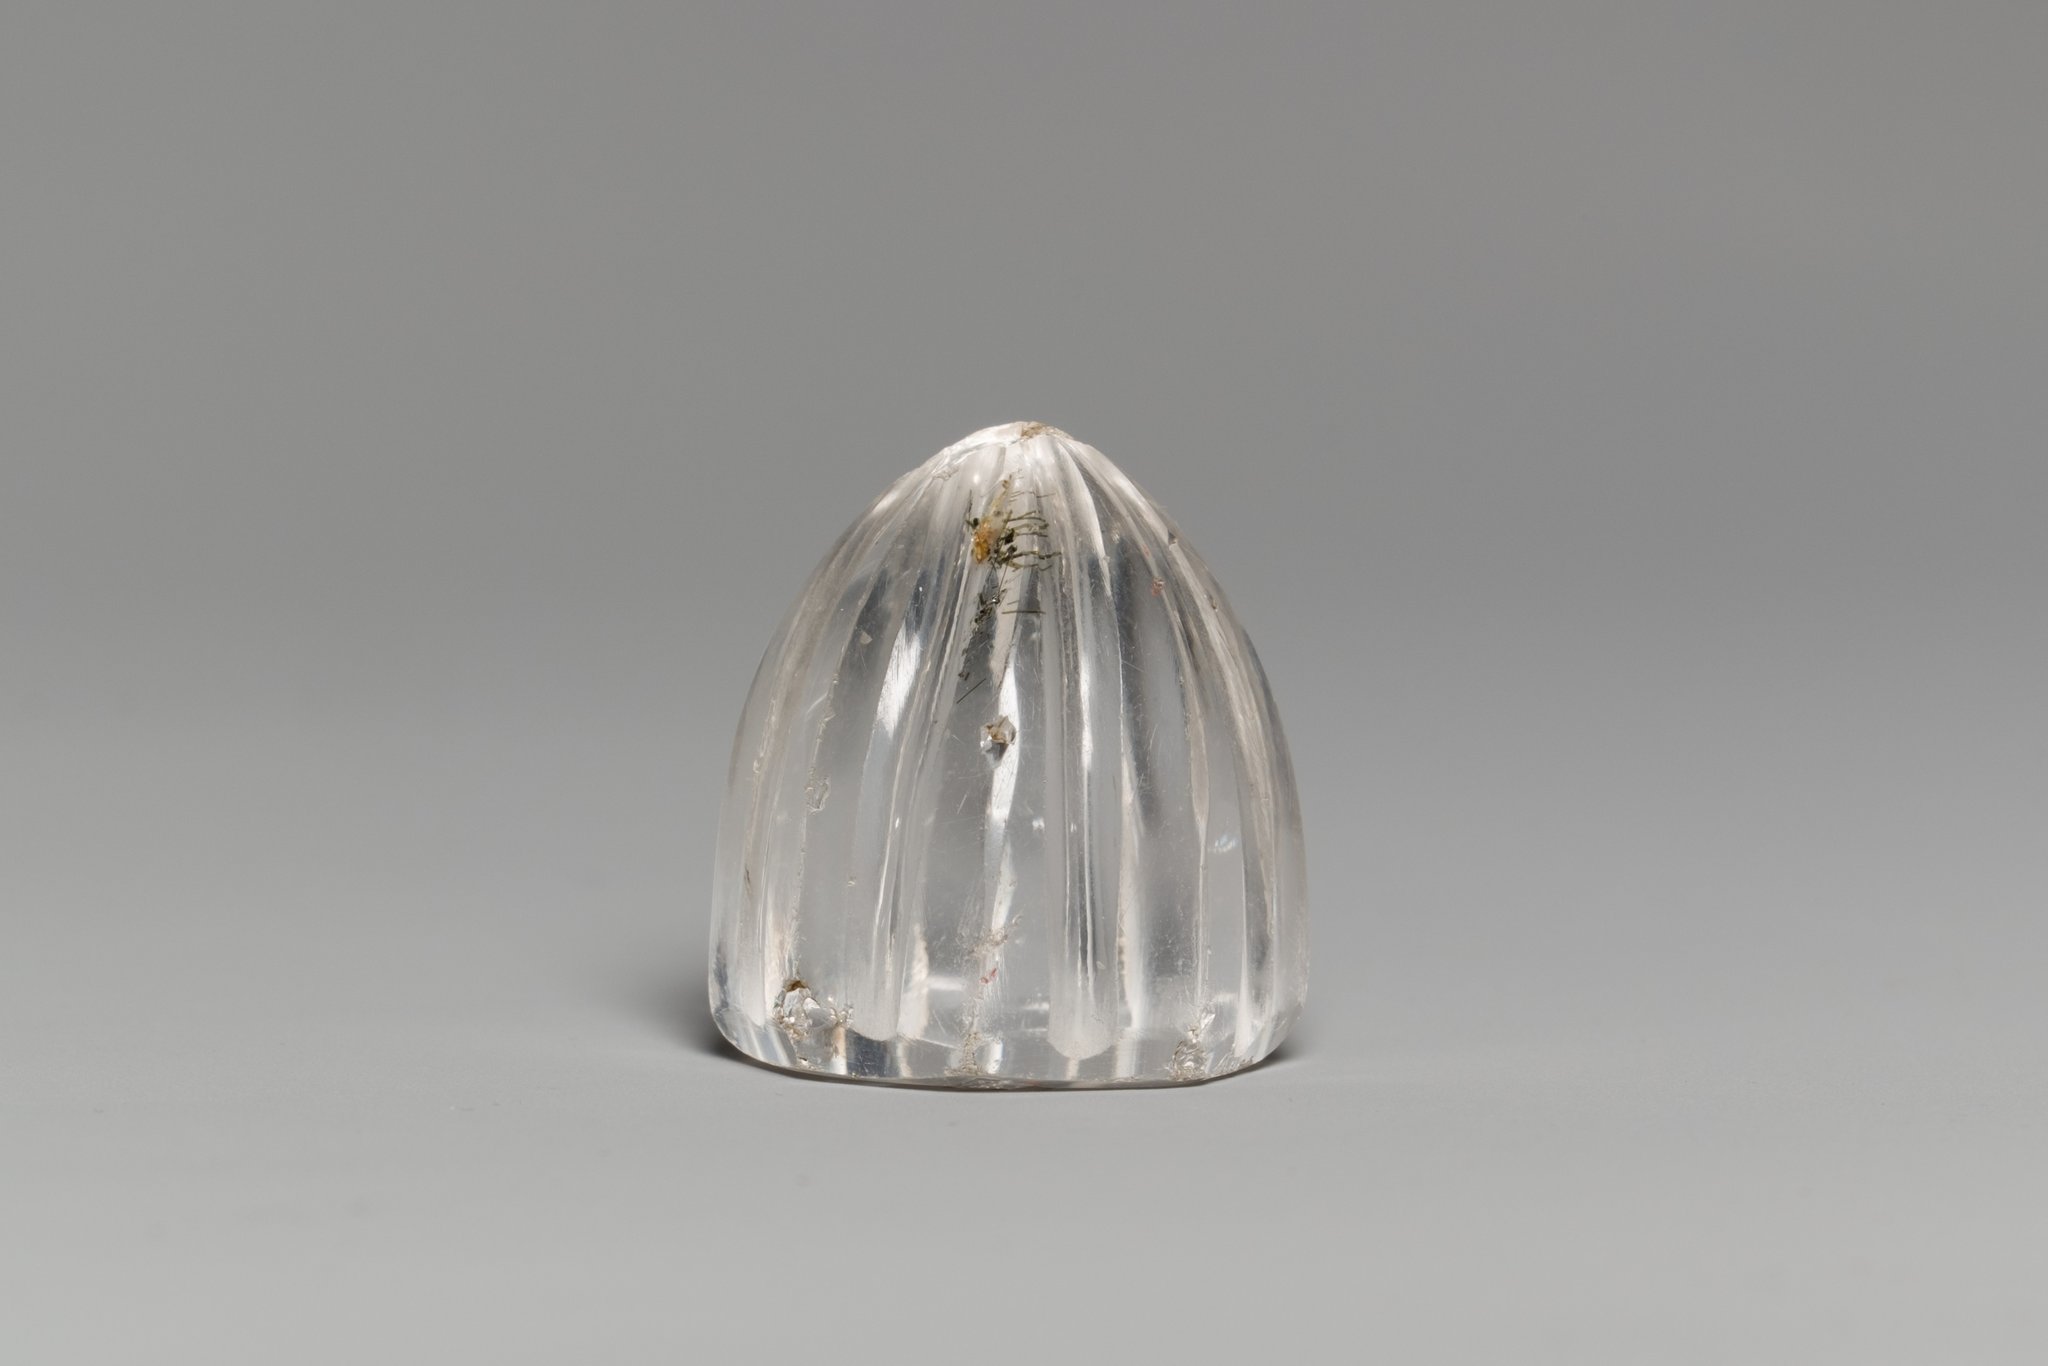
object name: chess or backgammon piece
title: Chess Piece, Pawn or Backgammon Piece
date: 901-1100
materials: quartz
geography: western islamic lands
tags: chess,games